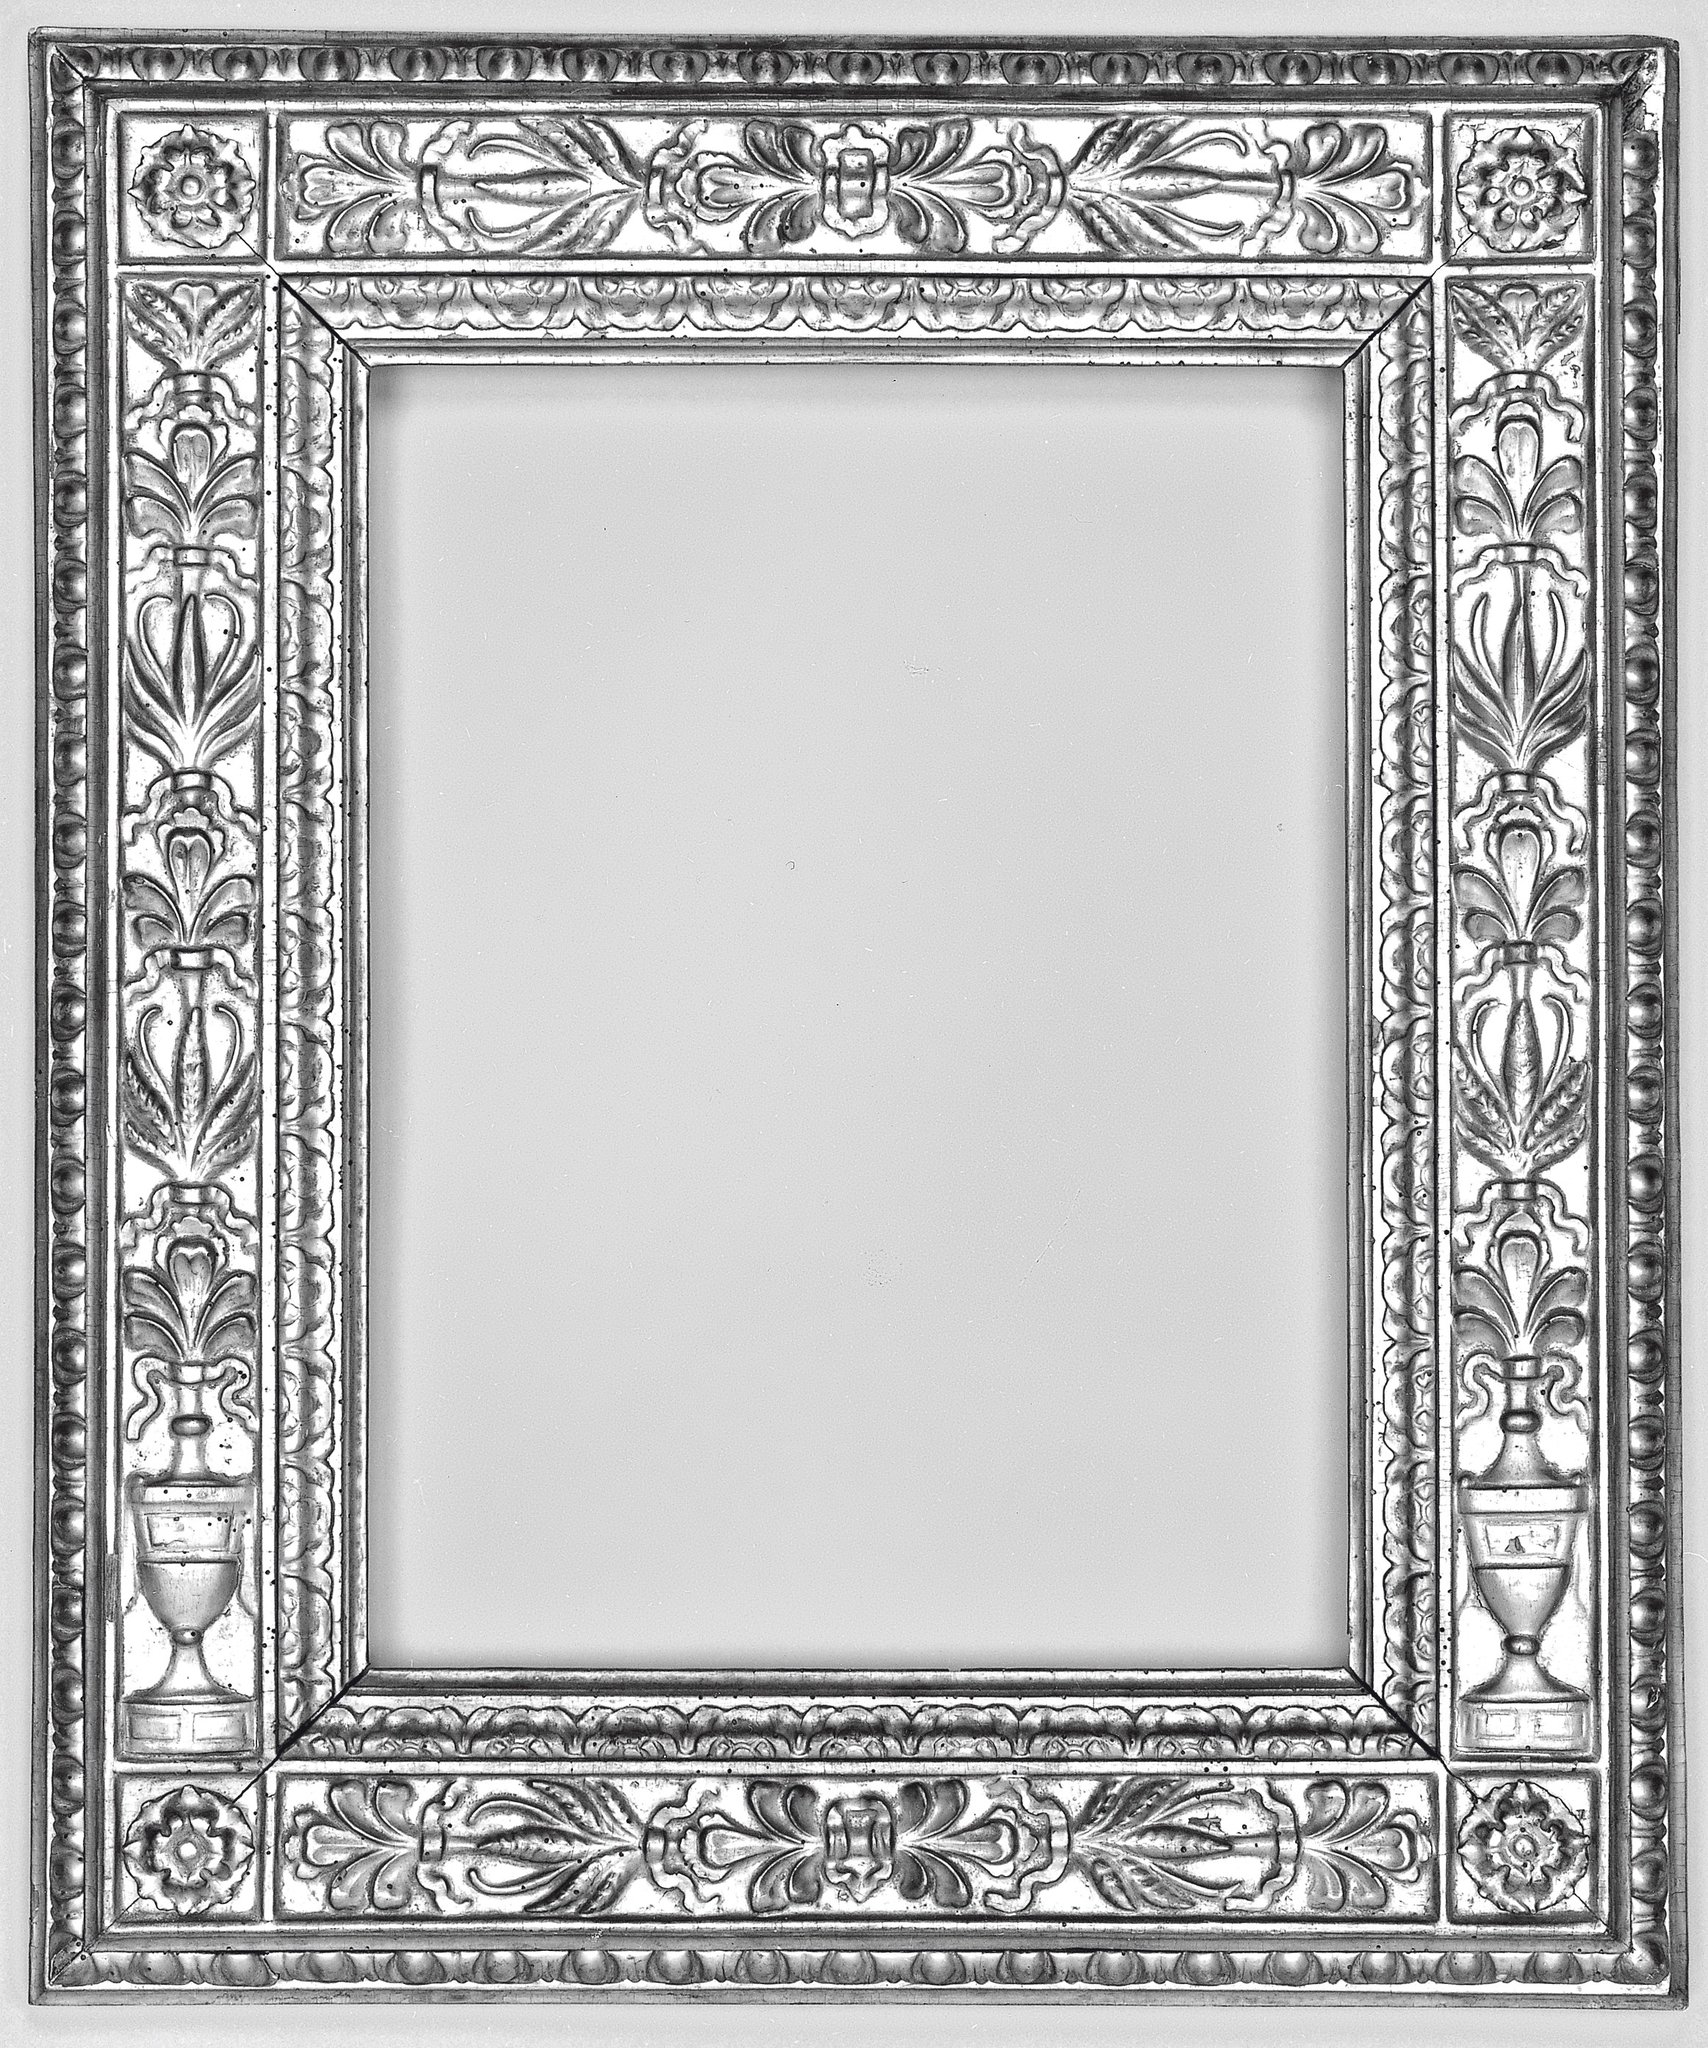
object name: frame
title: Cassetta frame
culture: italian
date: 1860-1870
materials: gilt, wood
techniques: carving